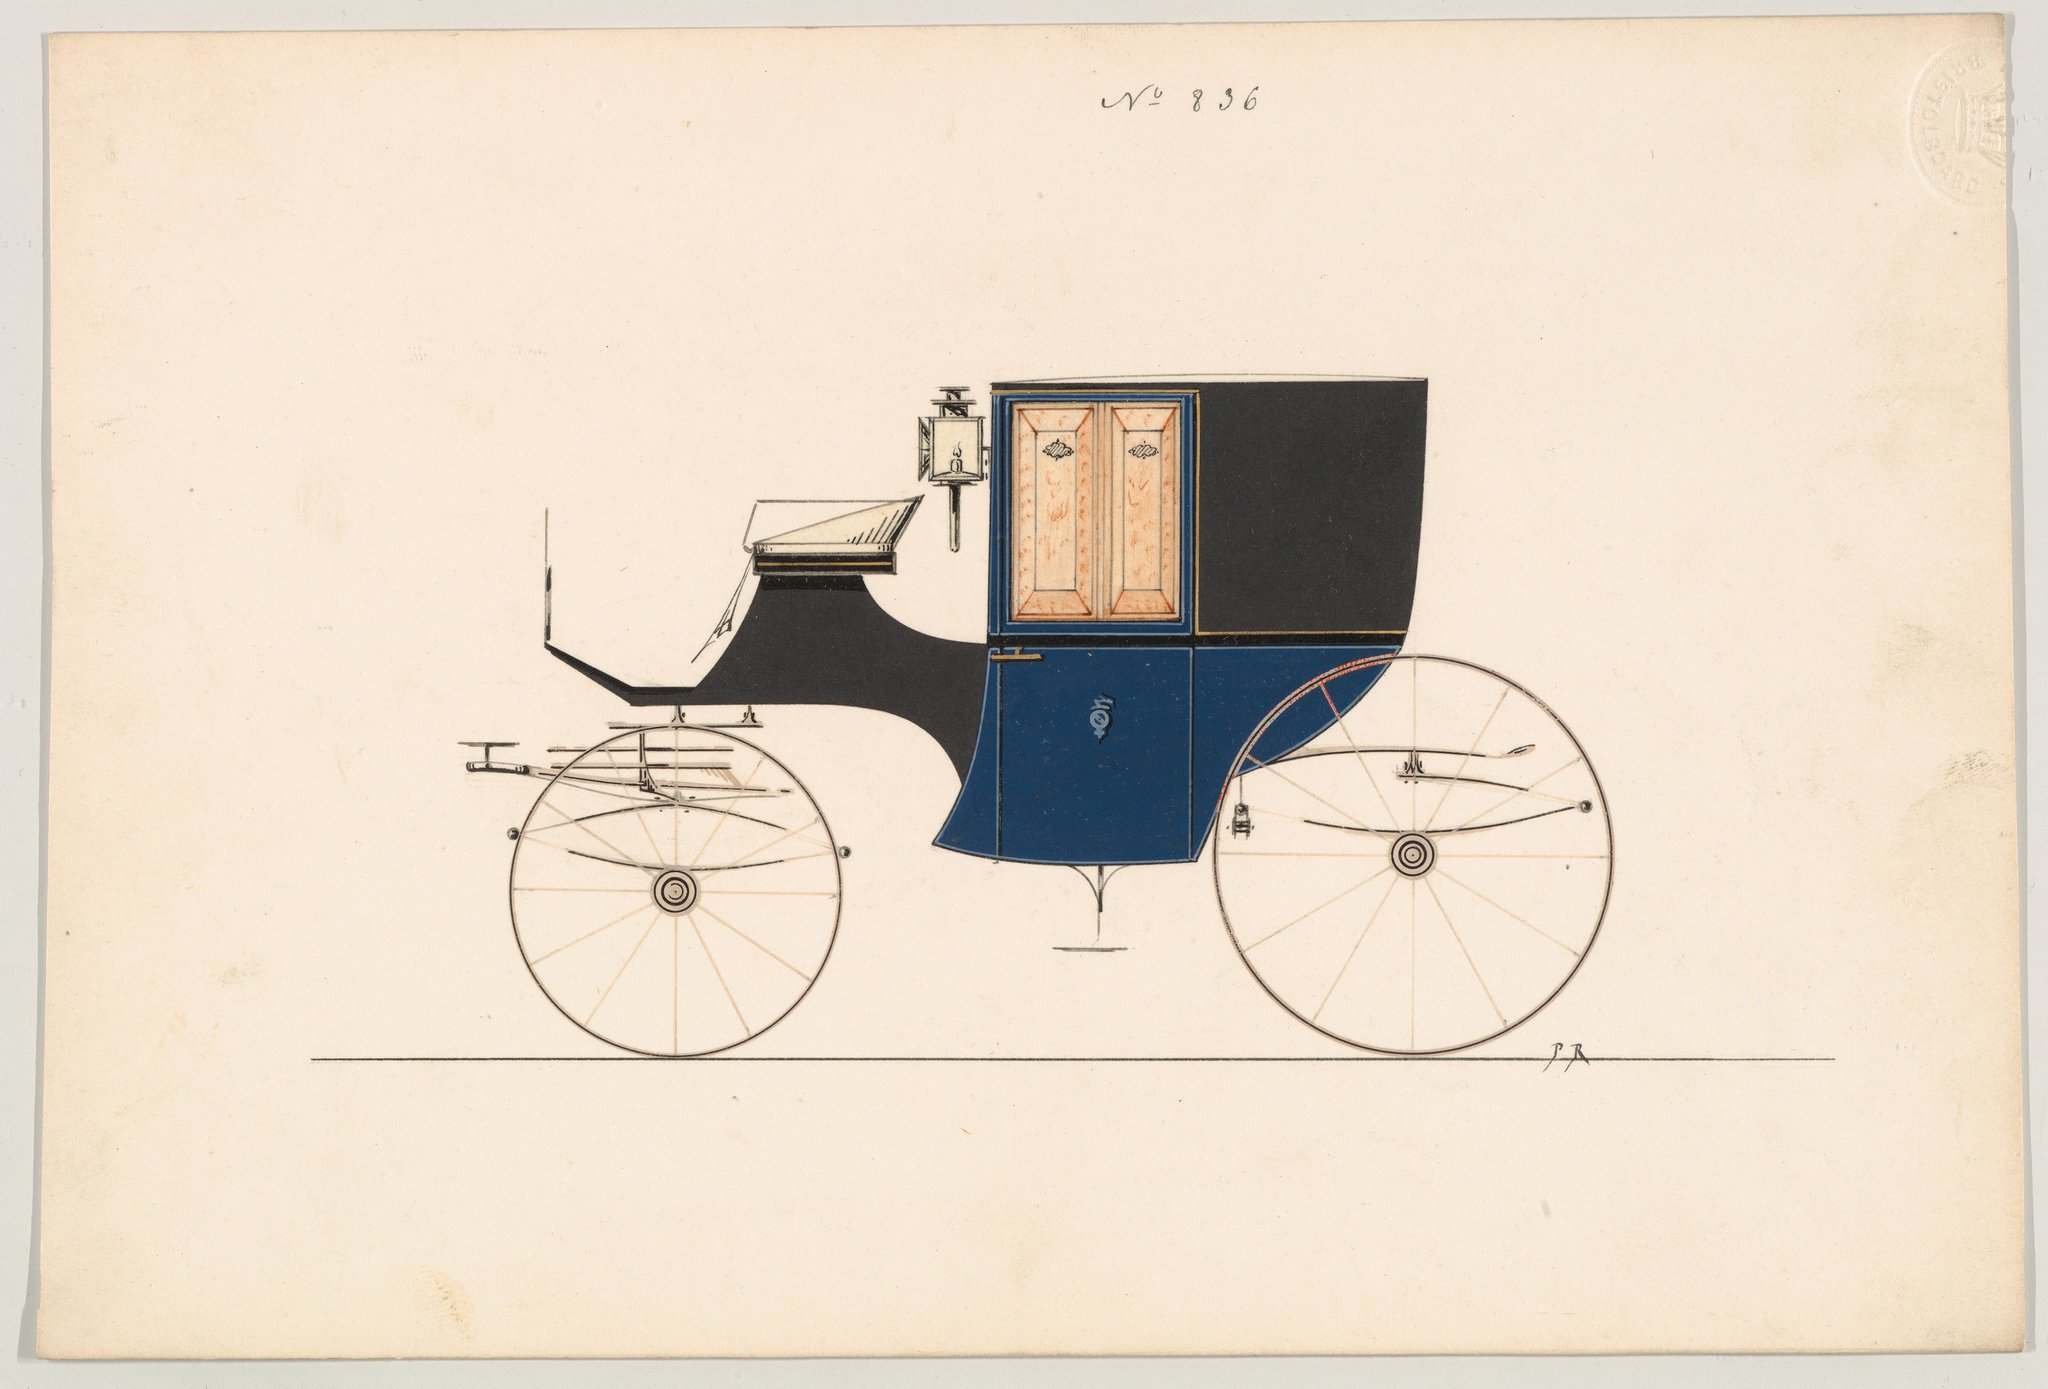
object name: drawing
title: Coupé # 836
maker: brewster & co.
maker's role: manufacturer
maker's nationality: american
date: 1865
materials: gouache, gum arabic, ink, watercolor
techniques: pen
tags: carriages